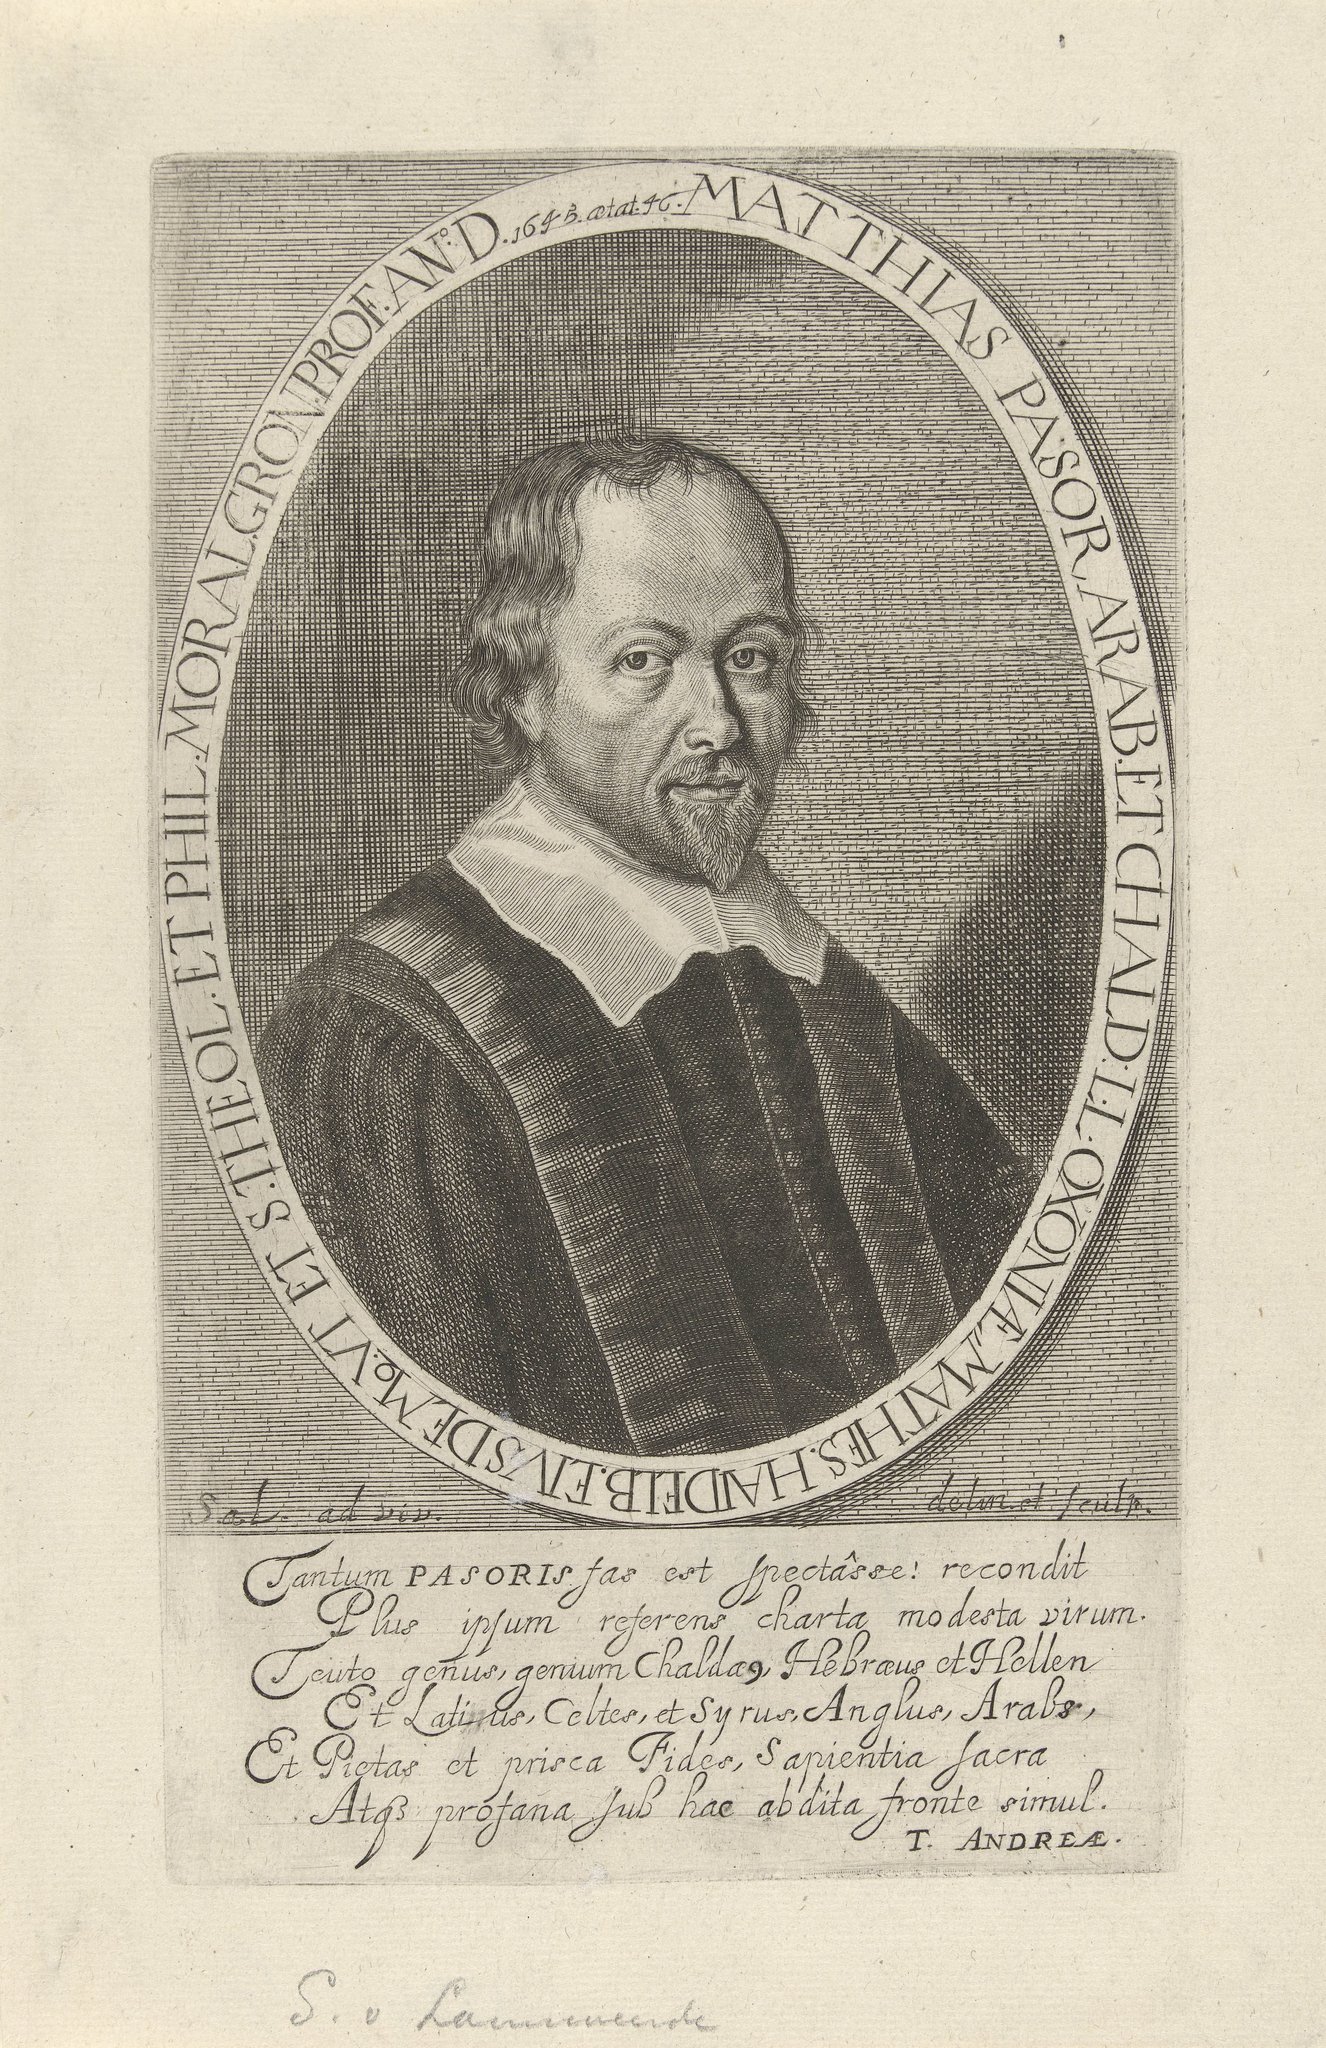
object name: print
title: Portret van Matthias Pasor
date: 1654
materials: paper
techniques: engraving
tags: matthias pasor, historical persons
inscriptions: collector's mark: Lugt 2228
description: Portretbuste in ovaal naar rechts van Matthias Pasor, hoogleraar in de theologie te Groningen, blootshoofds. Op de ovale omlijsting staat een randschrift in Latijn, in de marge een zesregelig Latijns vers.